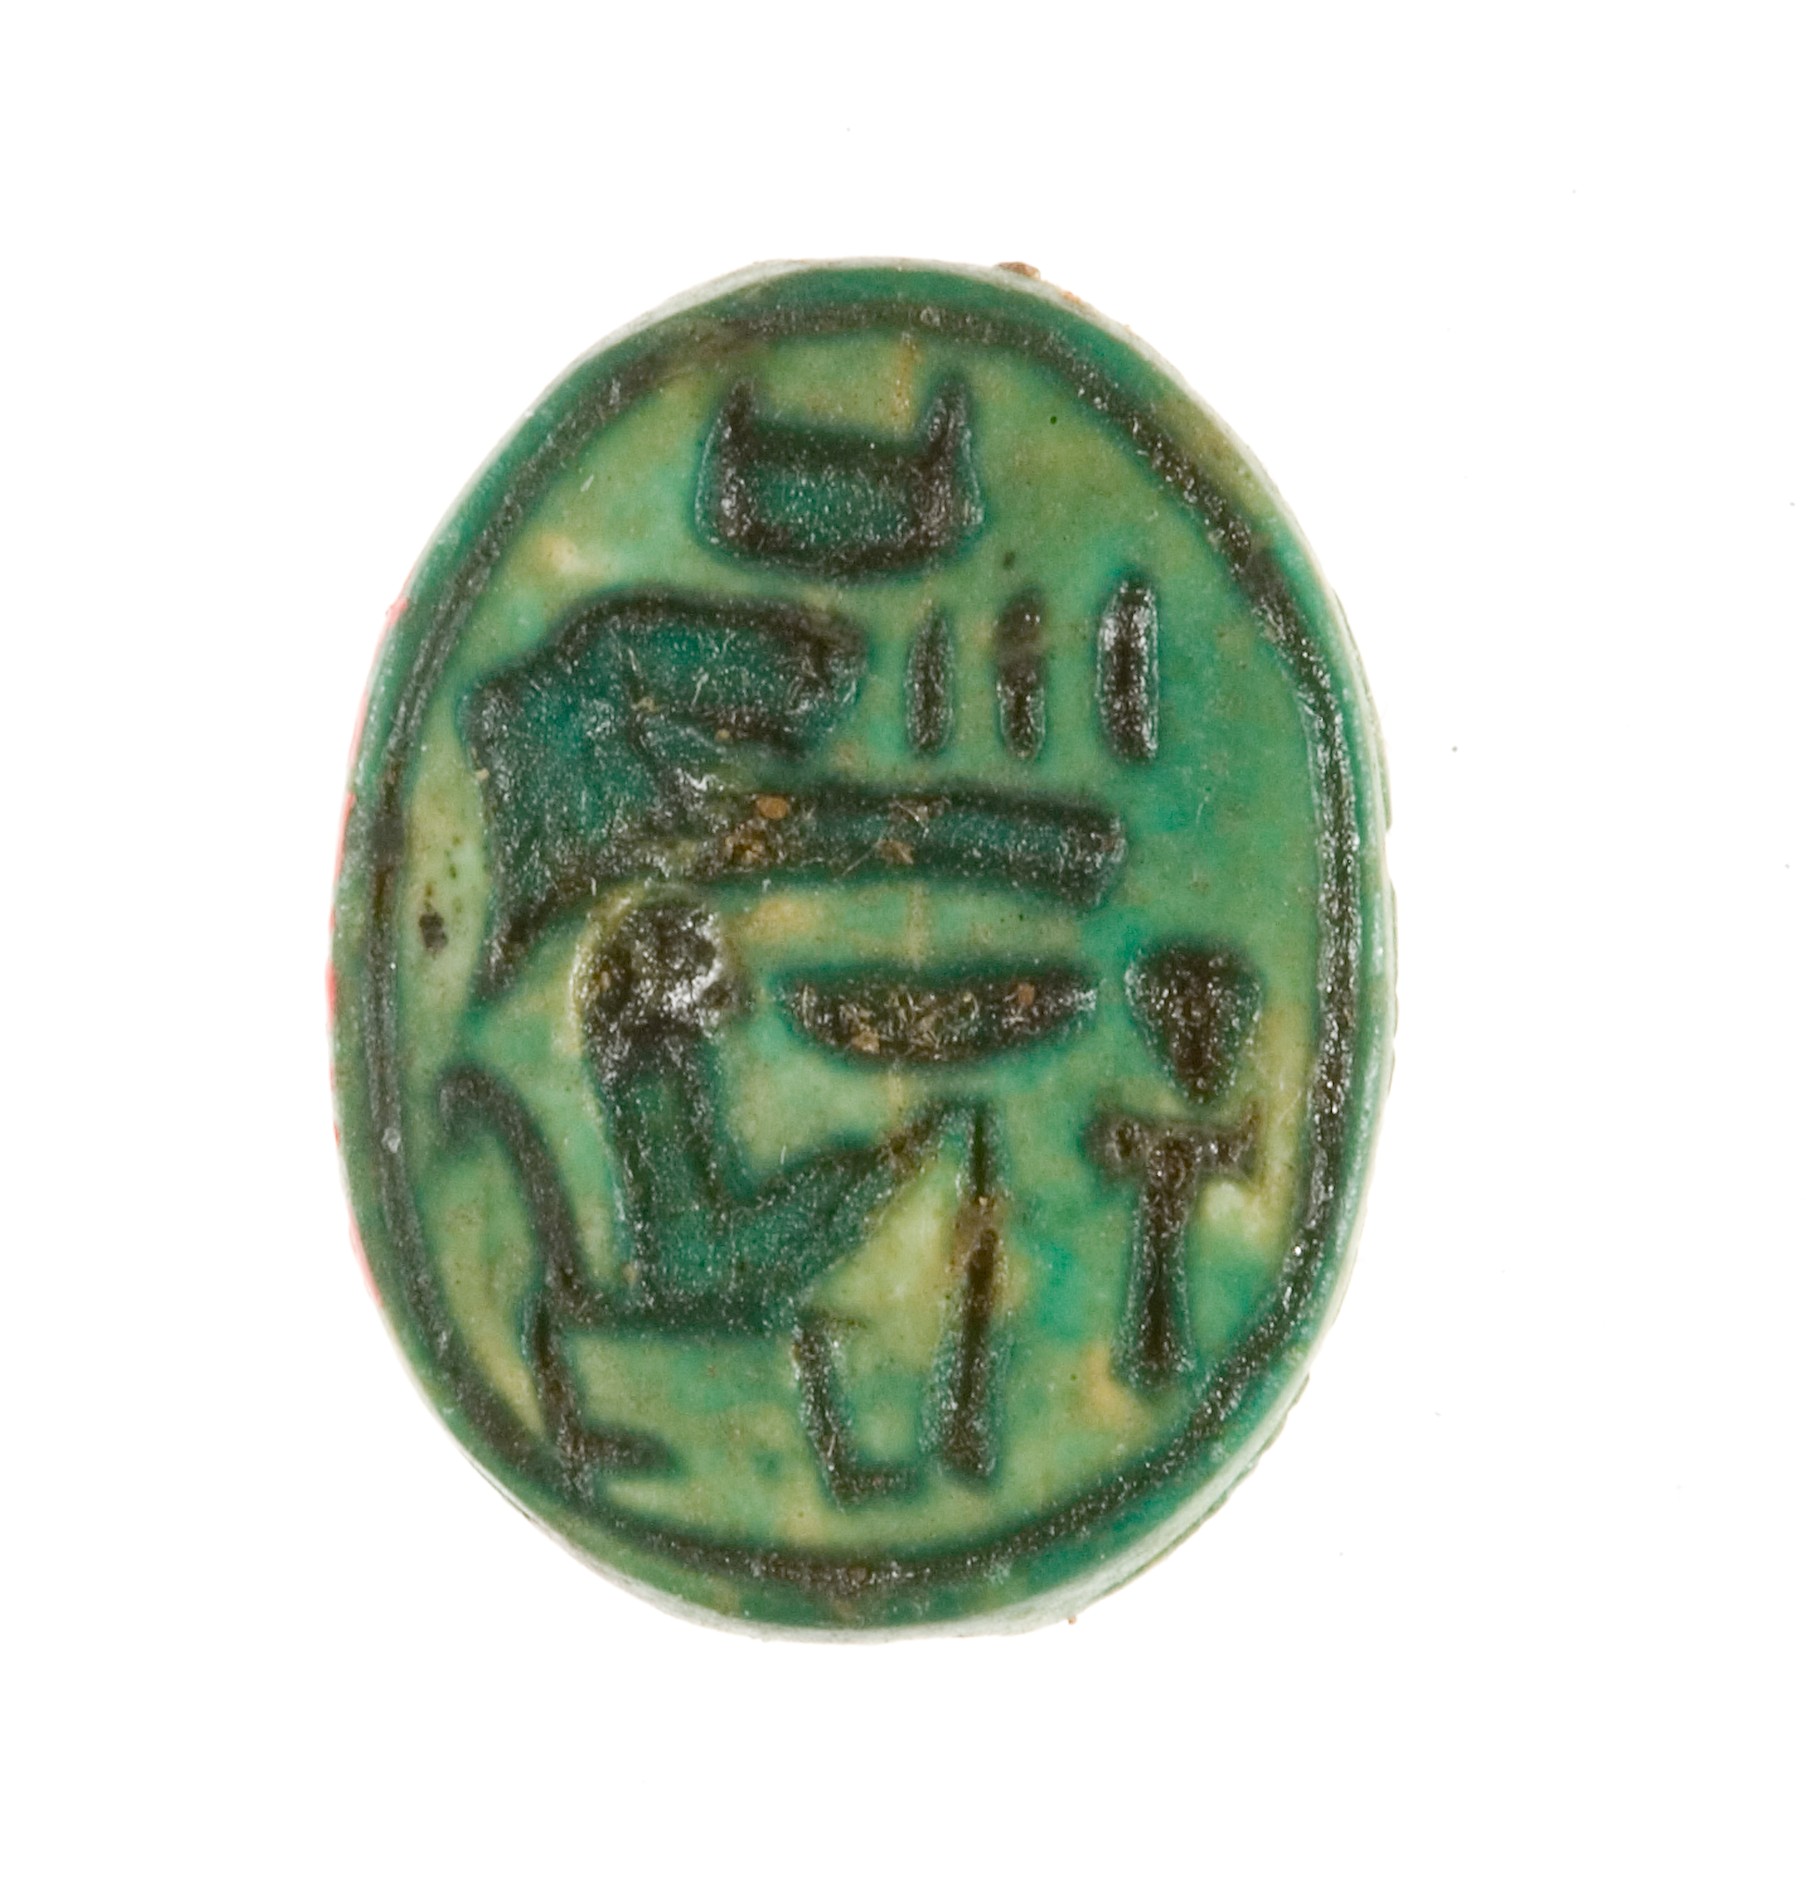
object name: scarab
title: Scarab Inscribed for the [God's] Wife Hatshepsut, Living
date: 1479-1458 BCE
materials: stone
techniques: glazing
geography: egypt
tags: hieroglyphs,scarabs